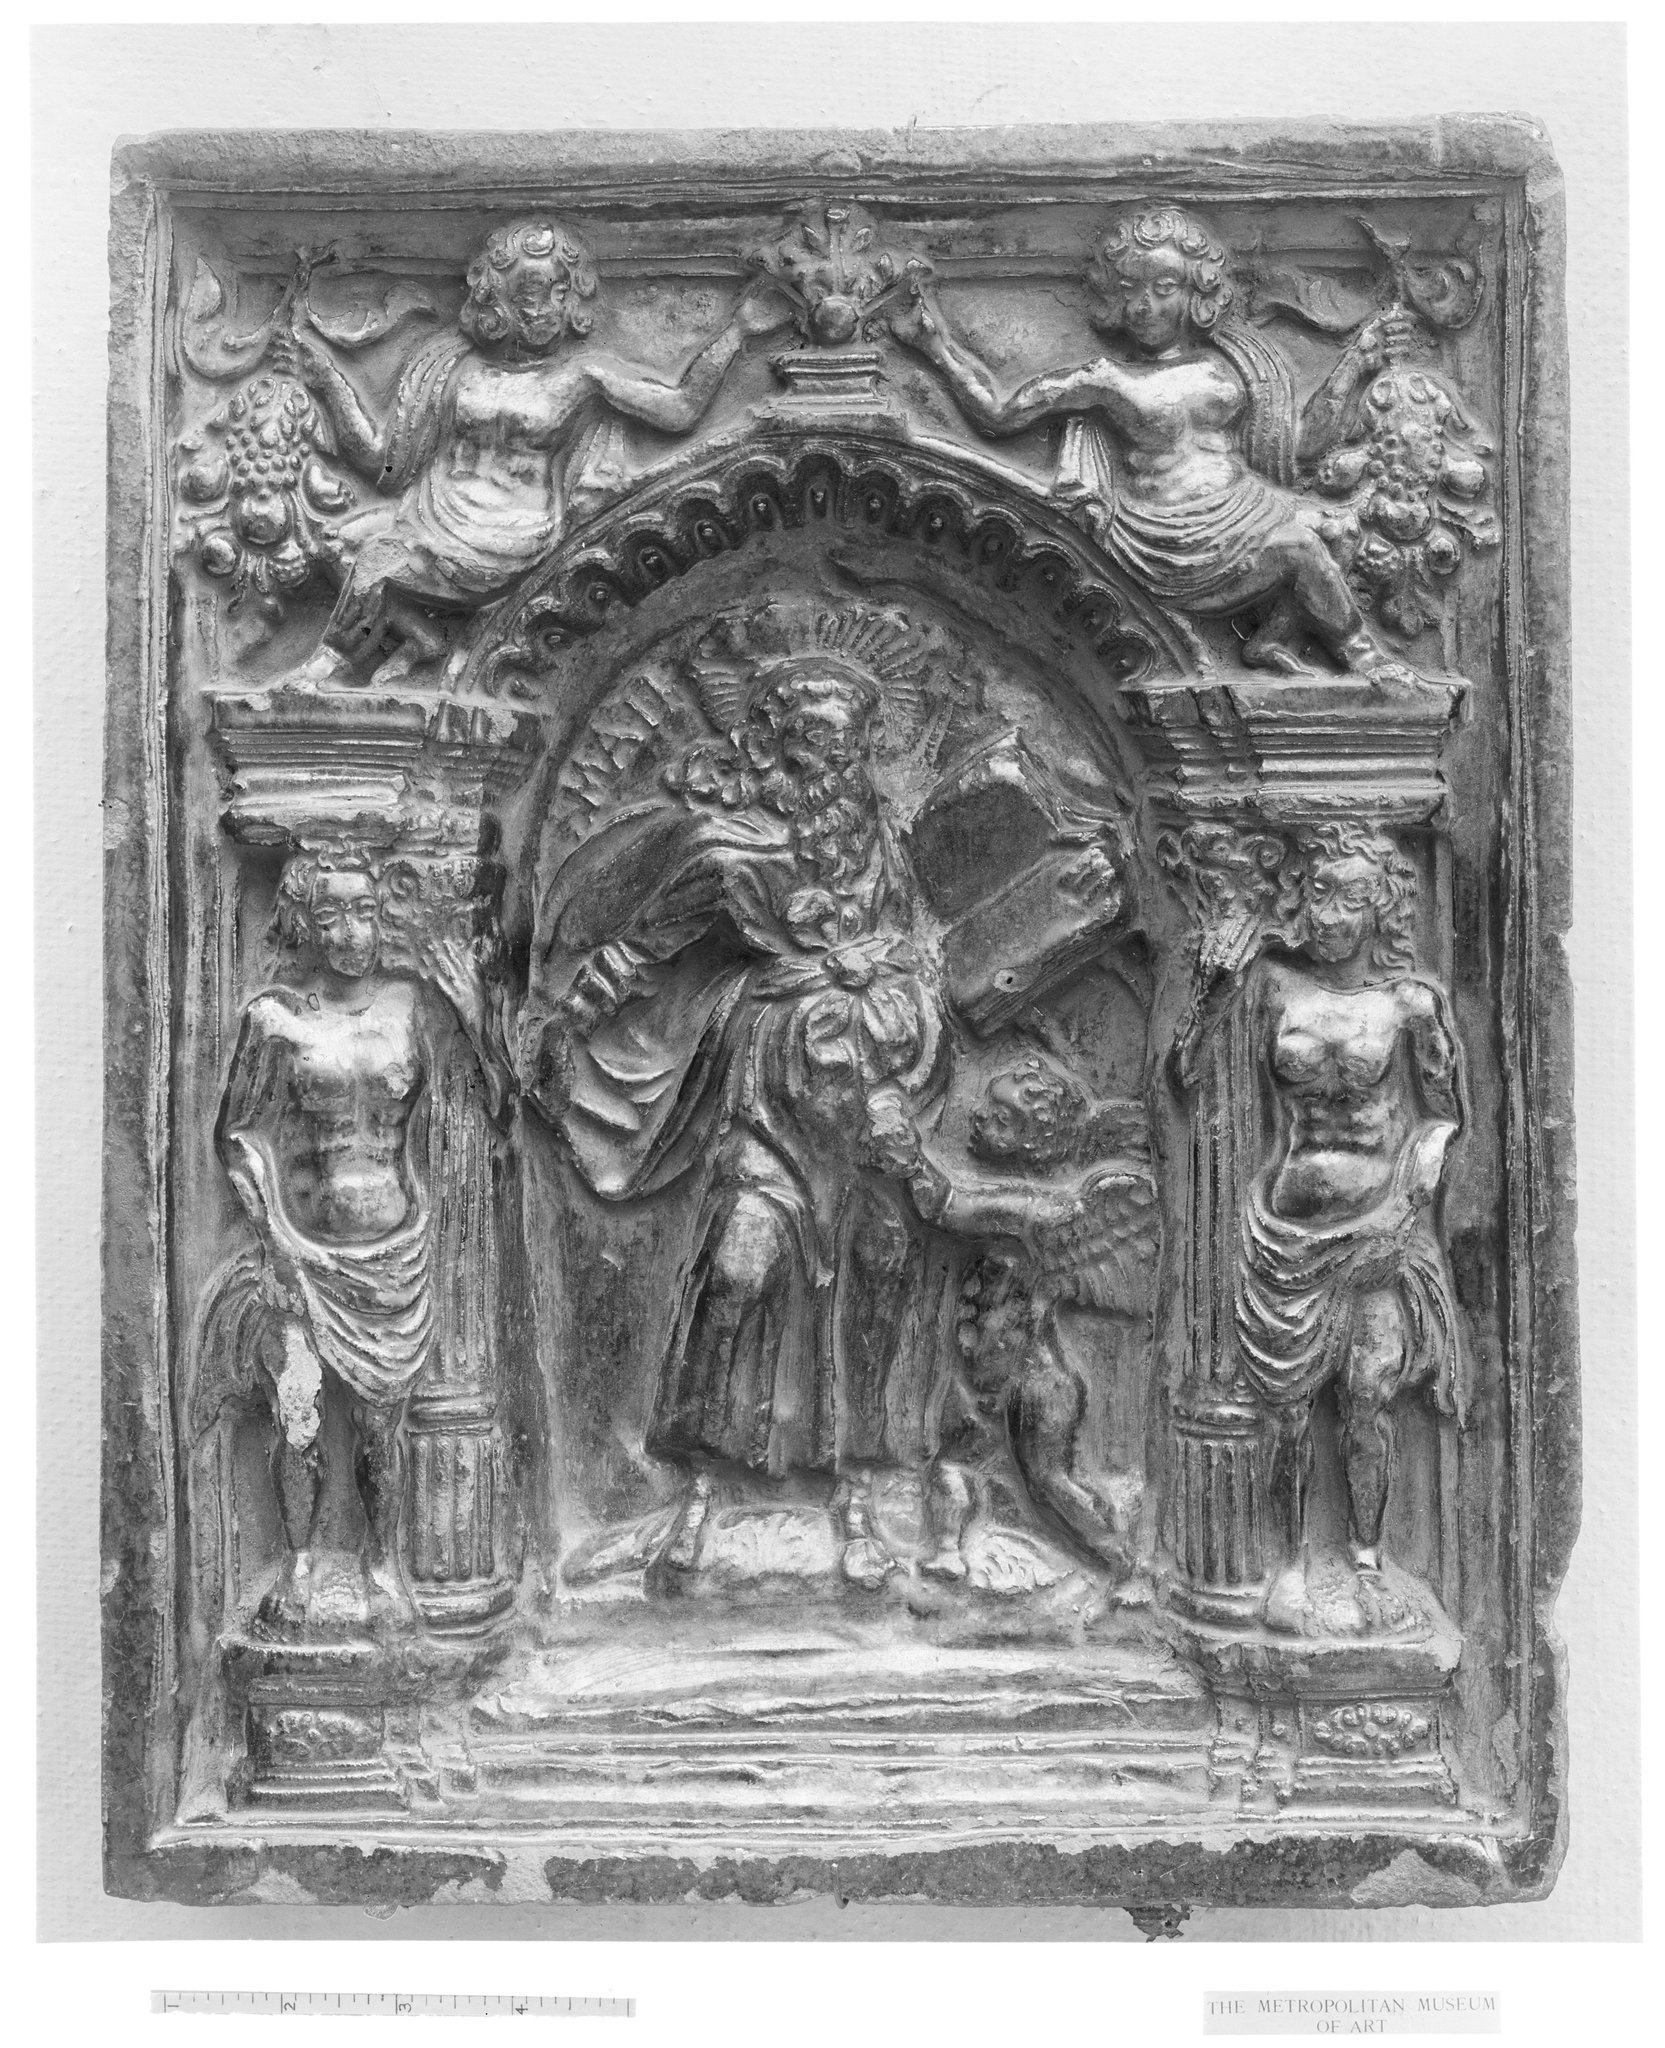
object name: stove panel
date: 1601-1633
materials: glaze, terracotta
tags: men,female nudes,angels